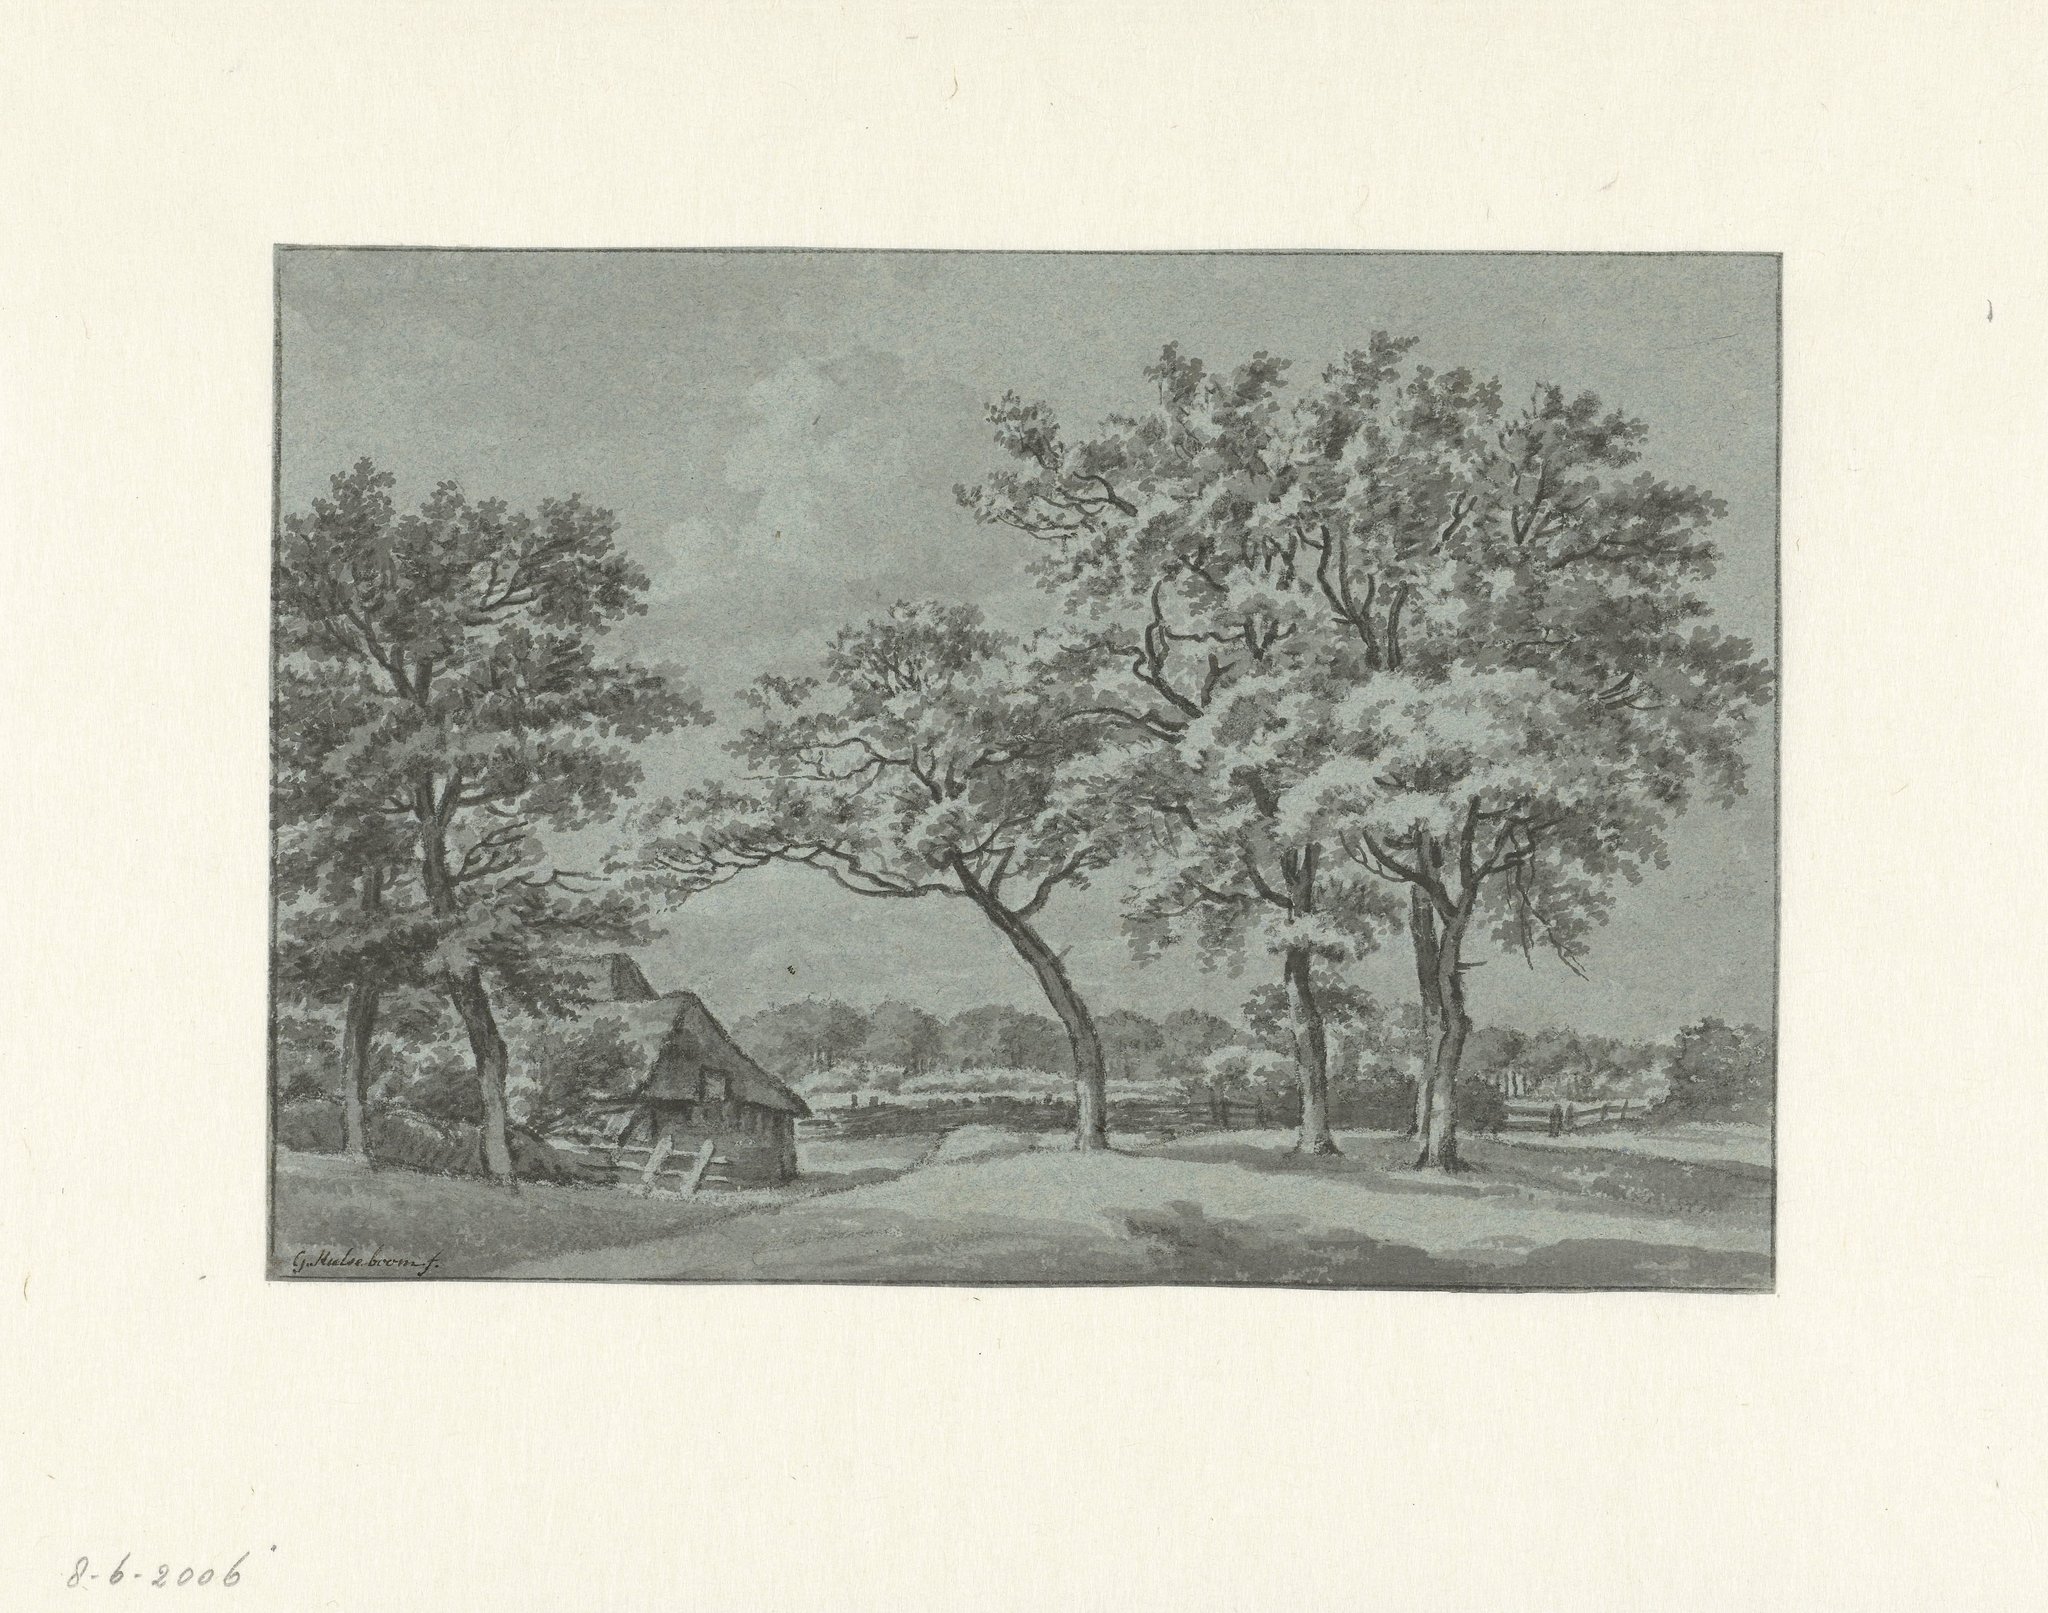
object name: drawing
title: Boerderij onder bomen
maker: gerrit hulseboom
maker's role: draughtsman, print maker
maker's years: 1784-1863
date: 1794-1863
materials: chalk, paper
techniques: brush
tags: farm or solitary house in landscape